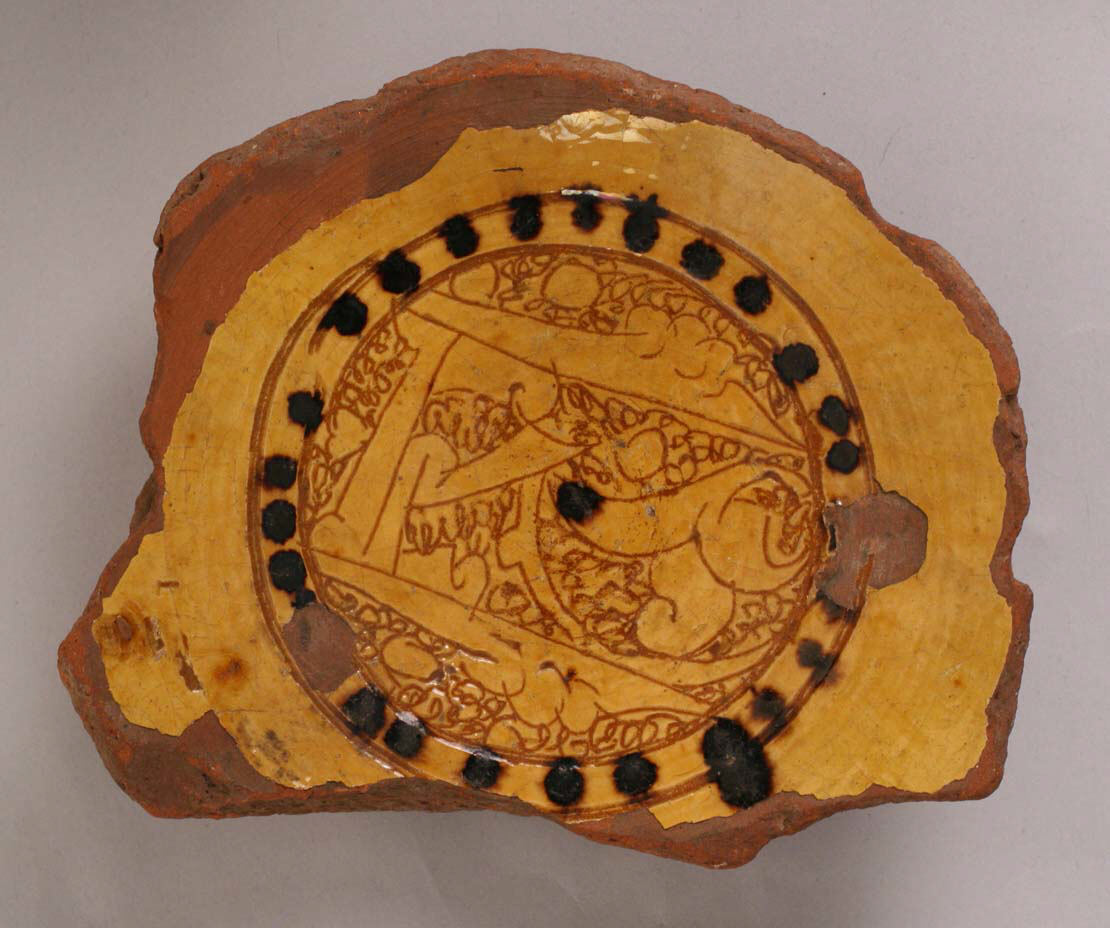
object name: fragment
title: Fragment of a Bowl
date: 1301-1500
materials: earthenware, glaze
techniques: coloring, incising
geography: egypt